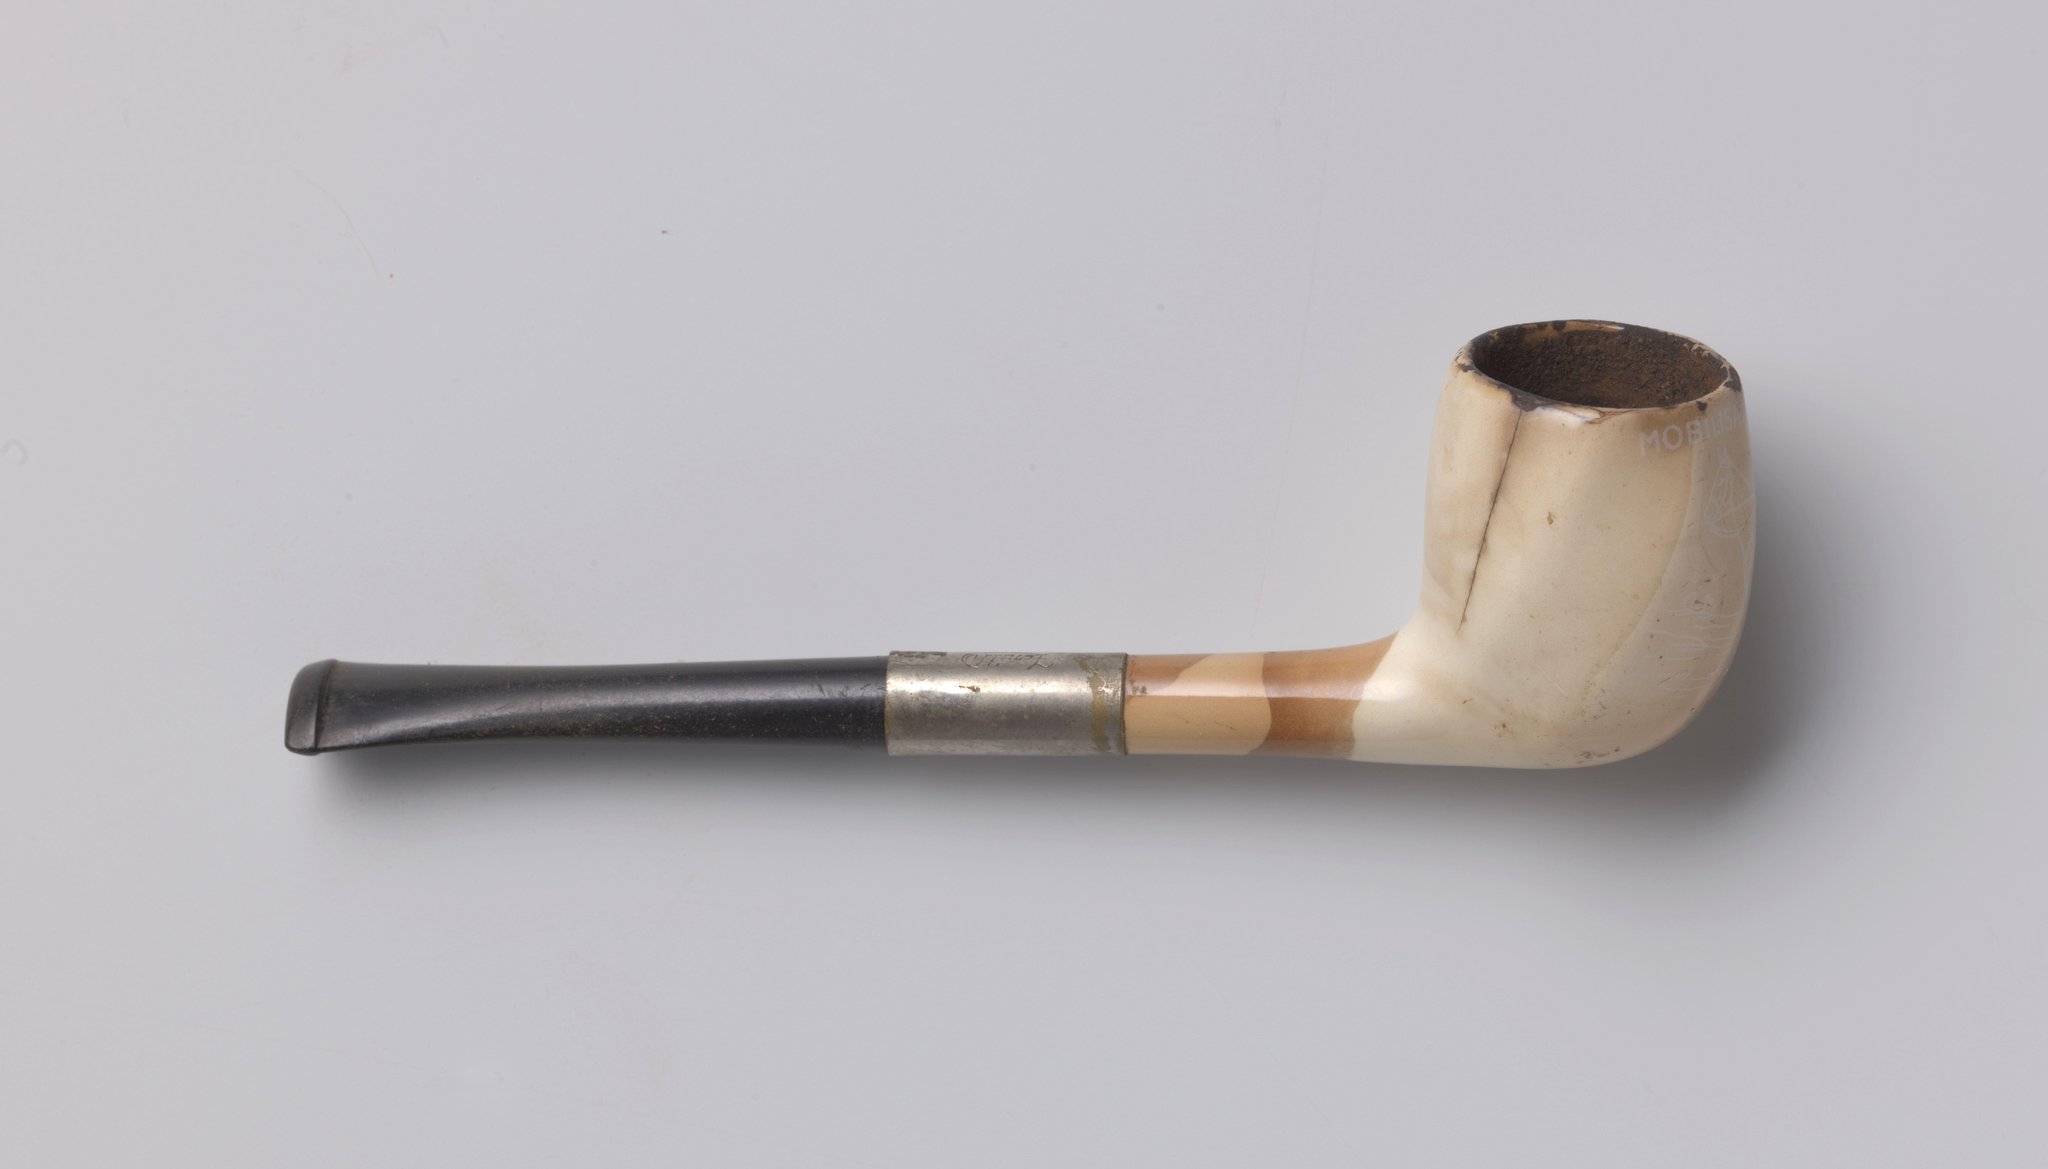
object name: pipe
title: Een doorroker met afbeelding van een cavalerist en de tekst 'Mobilisatie 1939'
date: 1939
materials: earthenware, plastic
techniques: firing, vitrification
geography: gouda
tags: print maker, draughtsman, jan petrus ponstijn, amsterdam, the hague, willem drees, netherlands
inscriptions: inscription: ‘Mobilisatie 1939’, mark: ‘Zenith’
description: Aardewerken pijp of 'doorroker' met witbeige kop, van binnen geblakerd, met een voorstelling in witte lijnen: een cavalerist en een molen en 'mobilisatie 1939'. Verbindingsstuk met mondstuk van metaal met opschrift 'Zenith Gouda'. Mondstuk van zwart plastic.